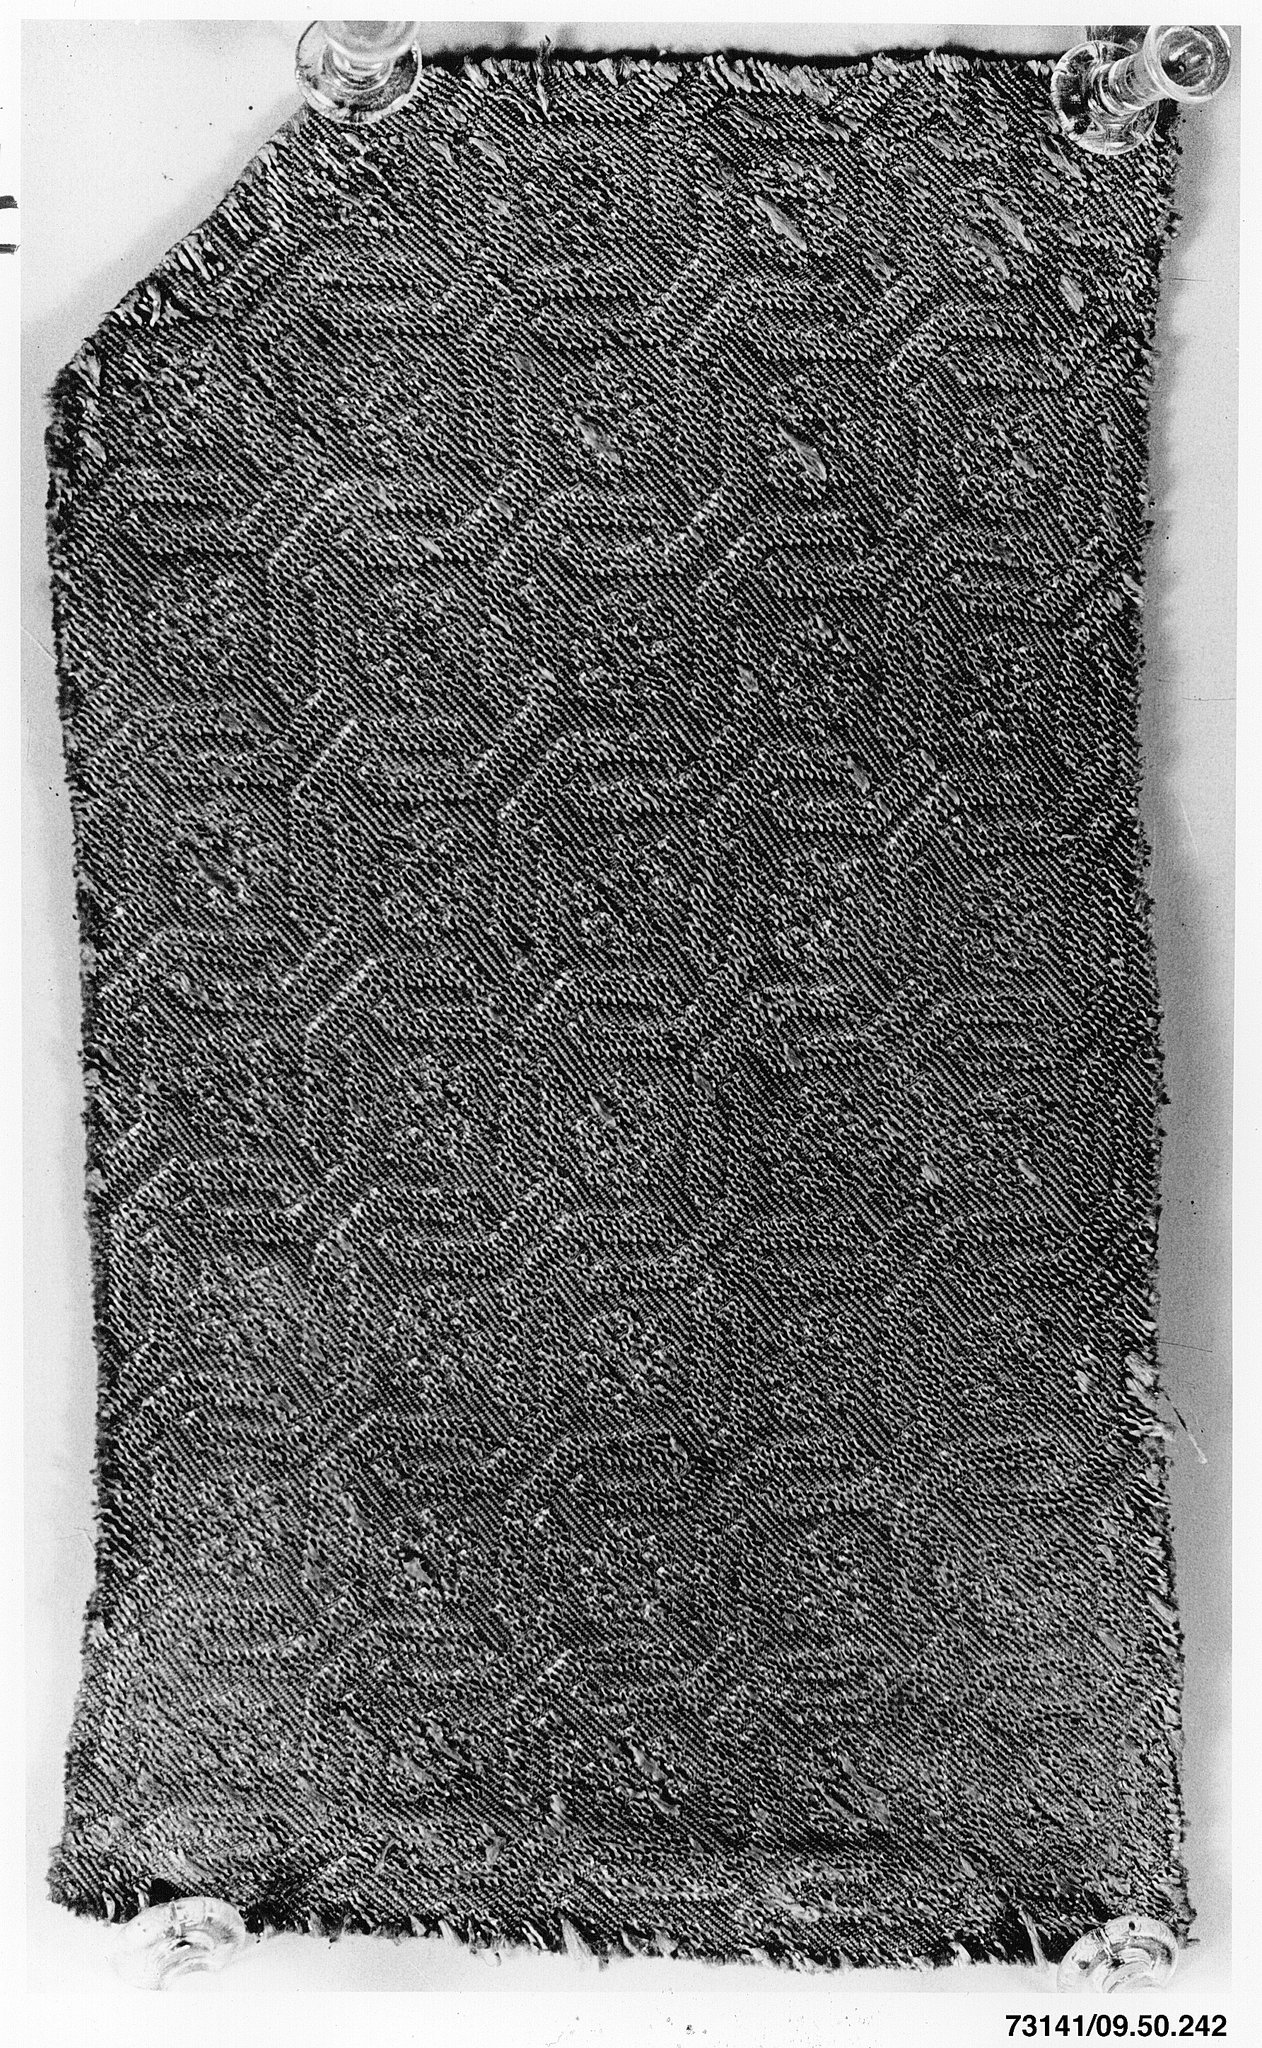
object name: piece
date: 1701-1733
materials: metal thread, silk